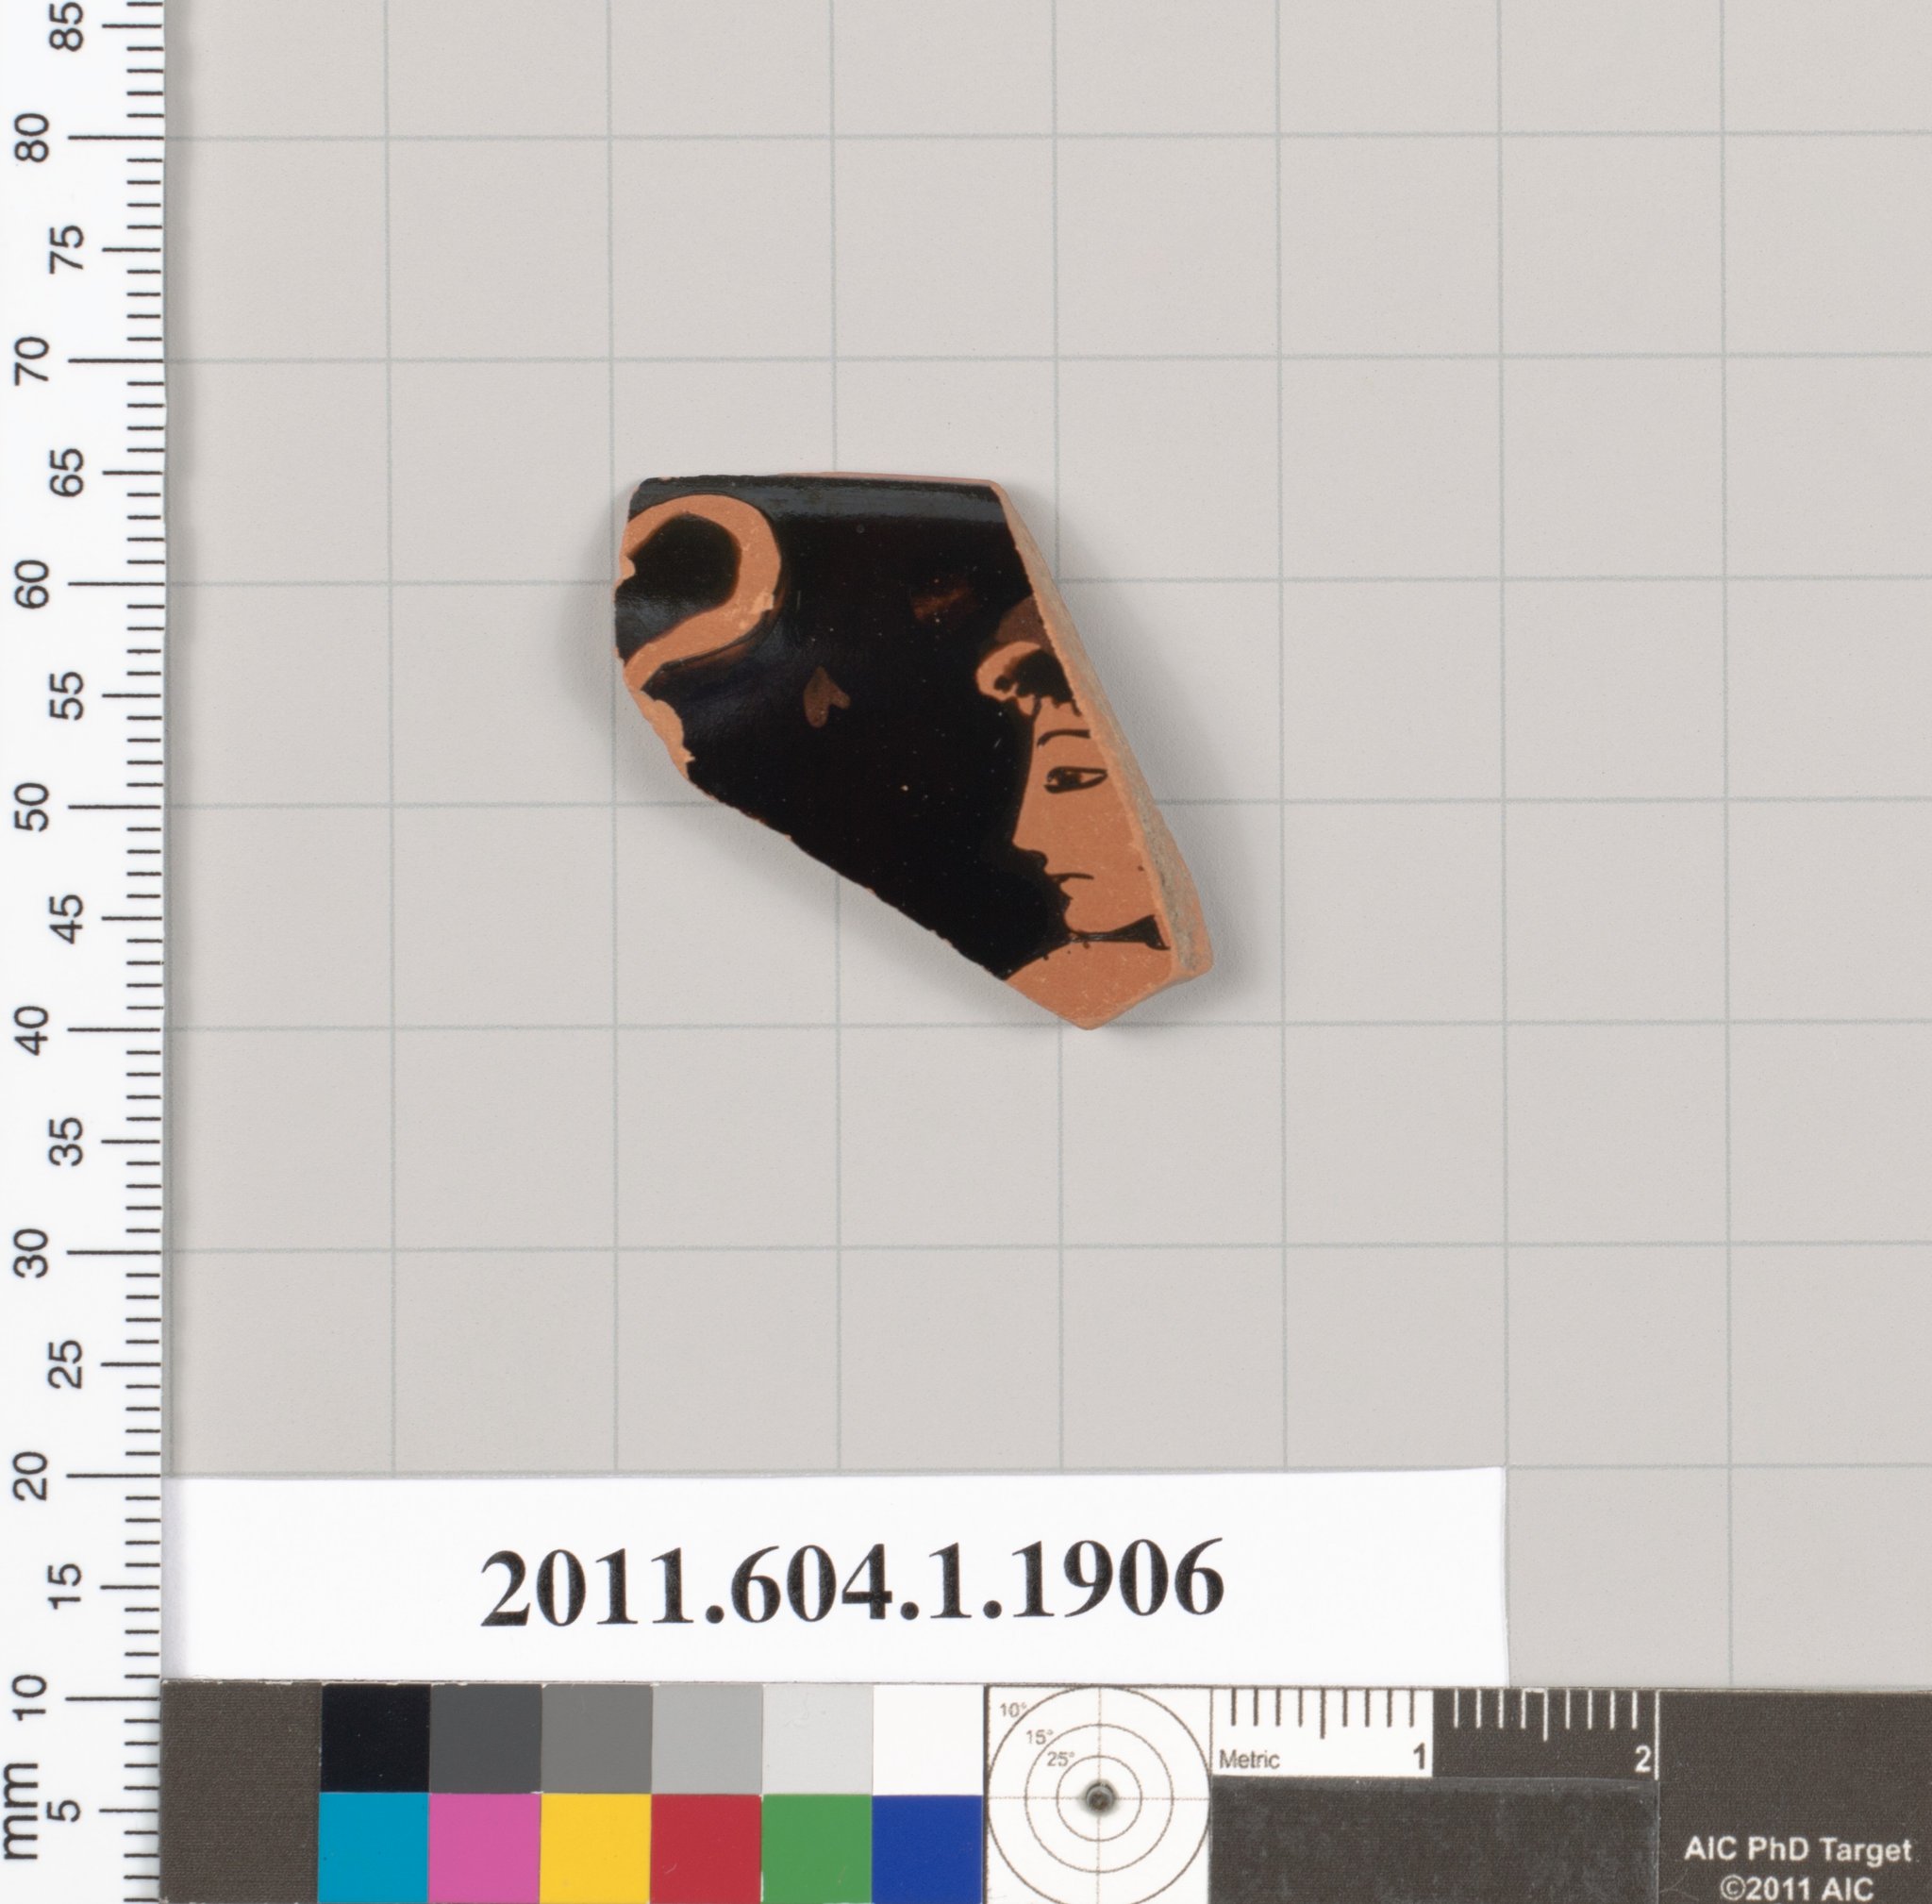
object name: kylix fragment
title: Terracotta rim fragment of a kylix (drinking cup)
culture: greek, attic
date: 534-501 BCE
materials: terracotta